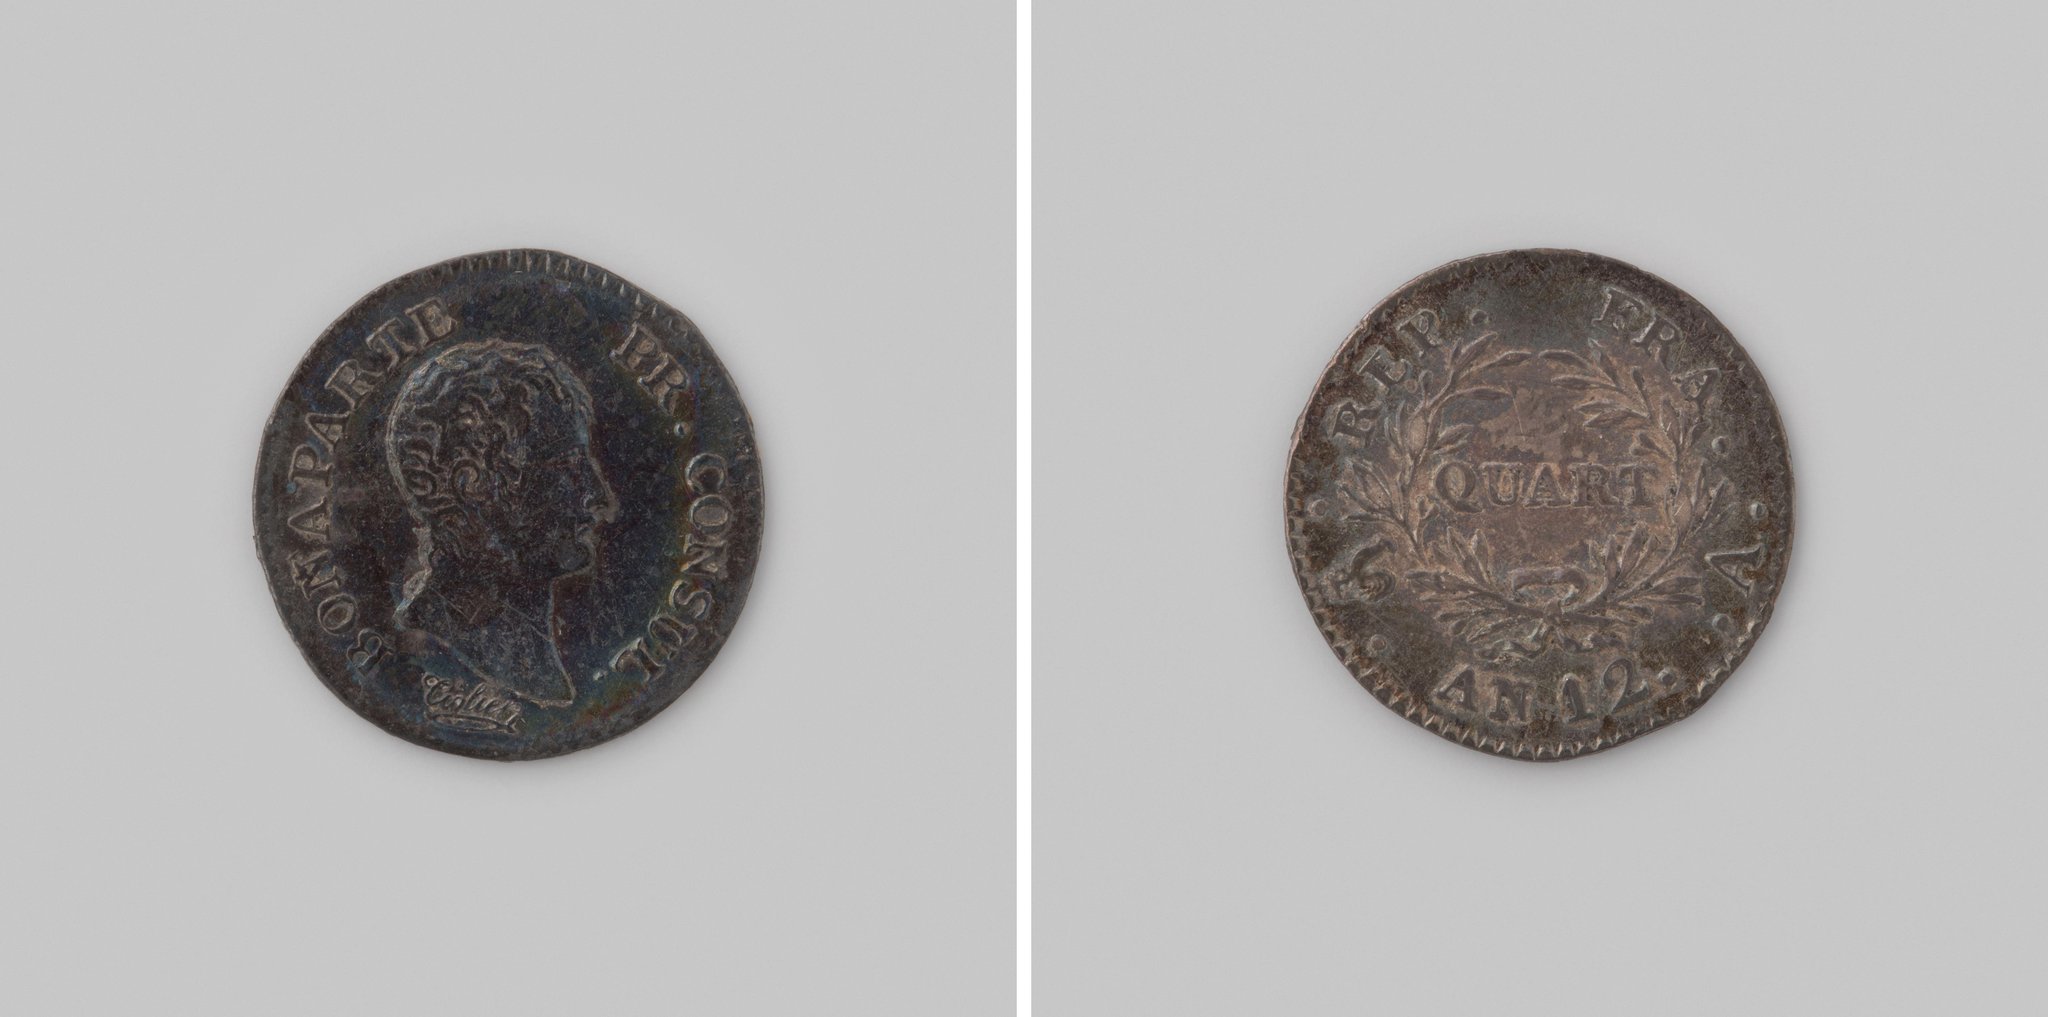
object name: coin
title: 1/4 franc uit Frankrijk van Napoleon als eerste consul, jaar 12 [=1803/4]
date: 1803-1804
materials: silver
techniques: striking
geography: paris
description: Zilveren munt. Voorzijde: borstbeeld van de eerste consul naar rechts. Daaronder jaartal. Keerzijde: binnen twee samengebonden lauriertakken waarde-aanduiding in een regel. Onderaan jaartal 12 in nieuwe telling. Rechts daarvan letter A [=Parijs]. Randversiering.